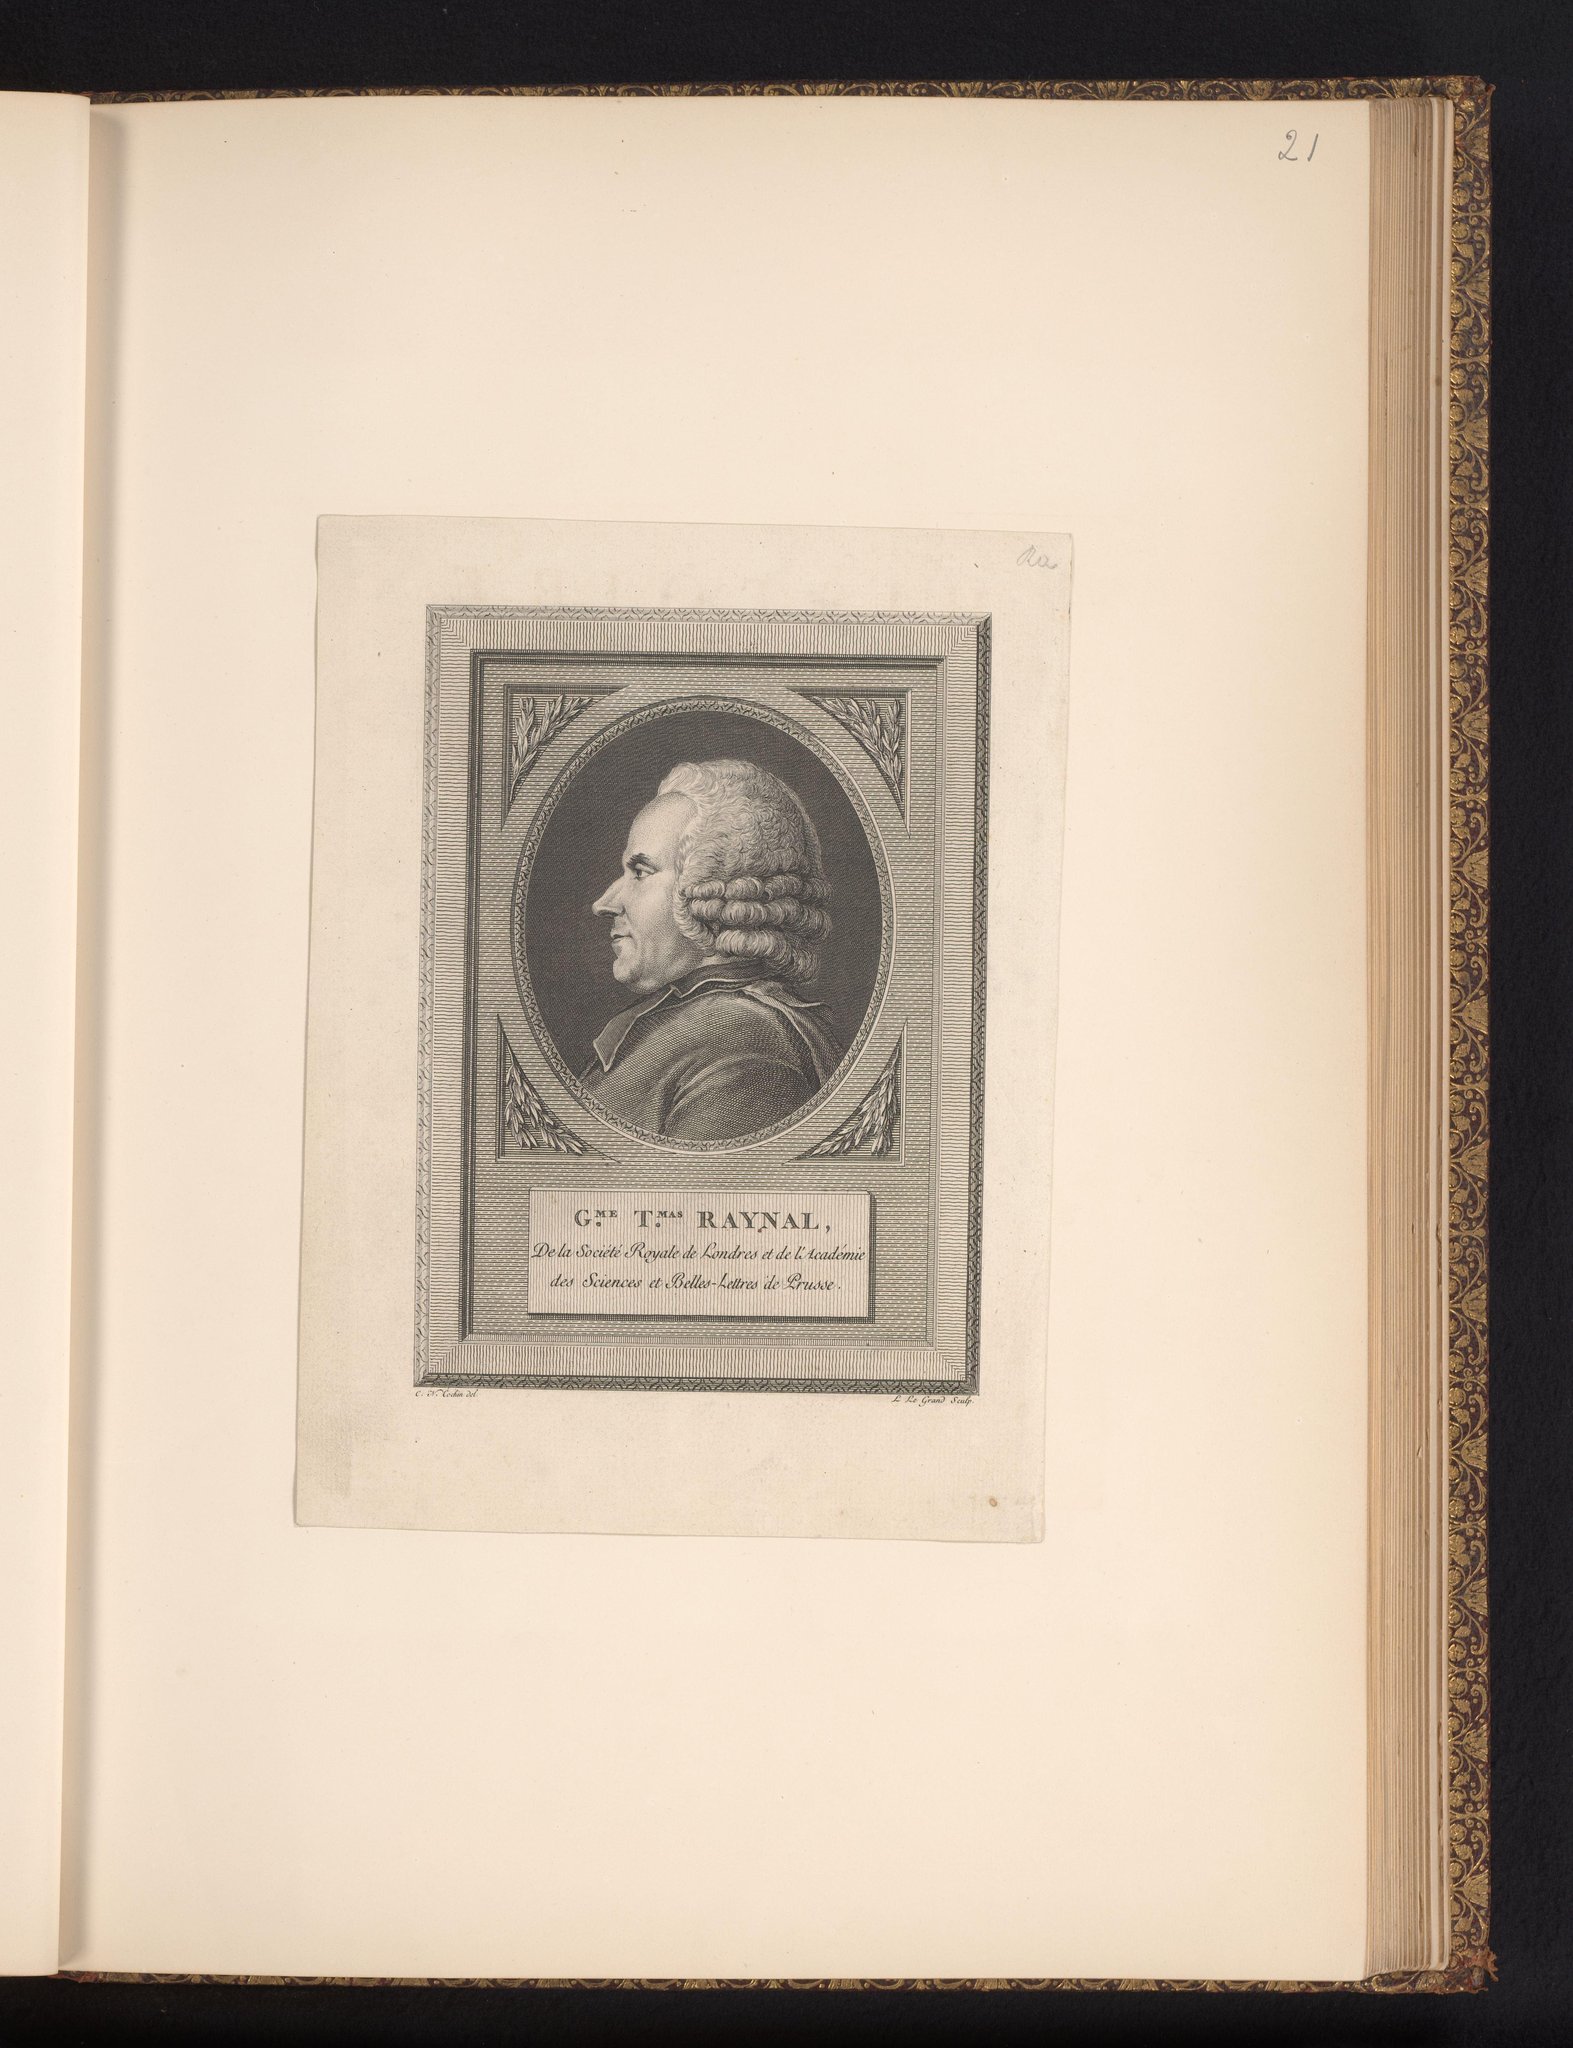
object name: print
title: Portret van Guillaume-Thomas François Raynal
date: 1773-1800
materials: paper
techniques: engraving, etching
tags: paris, historical persons